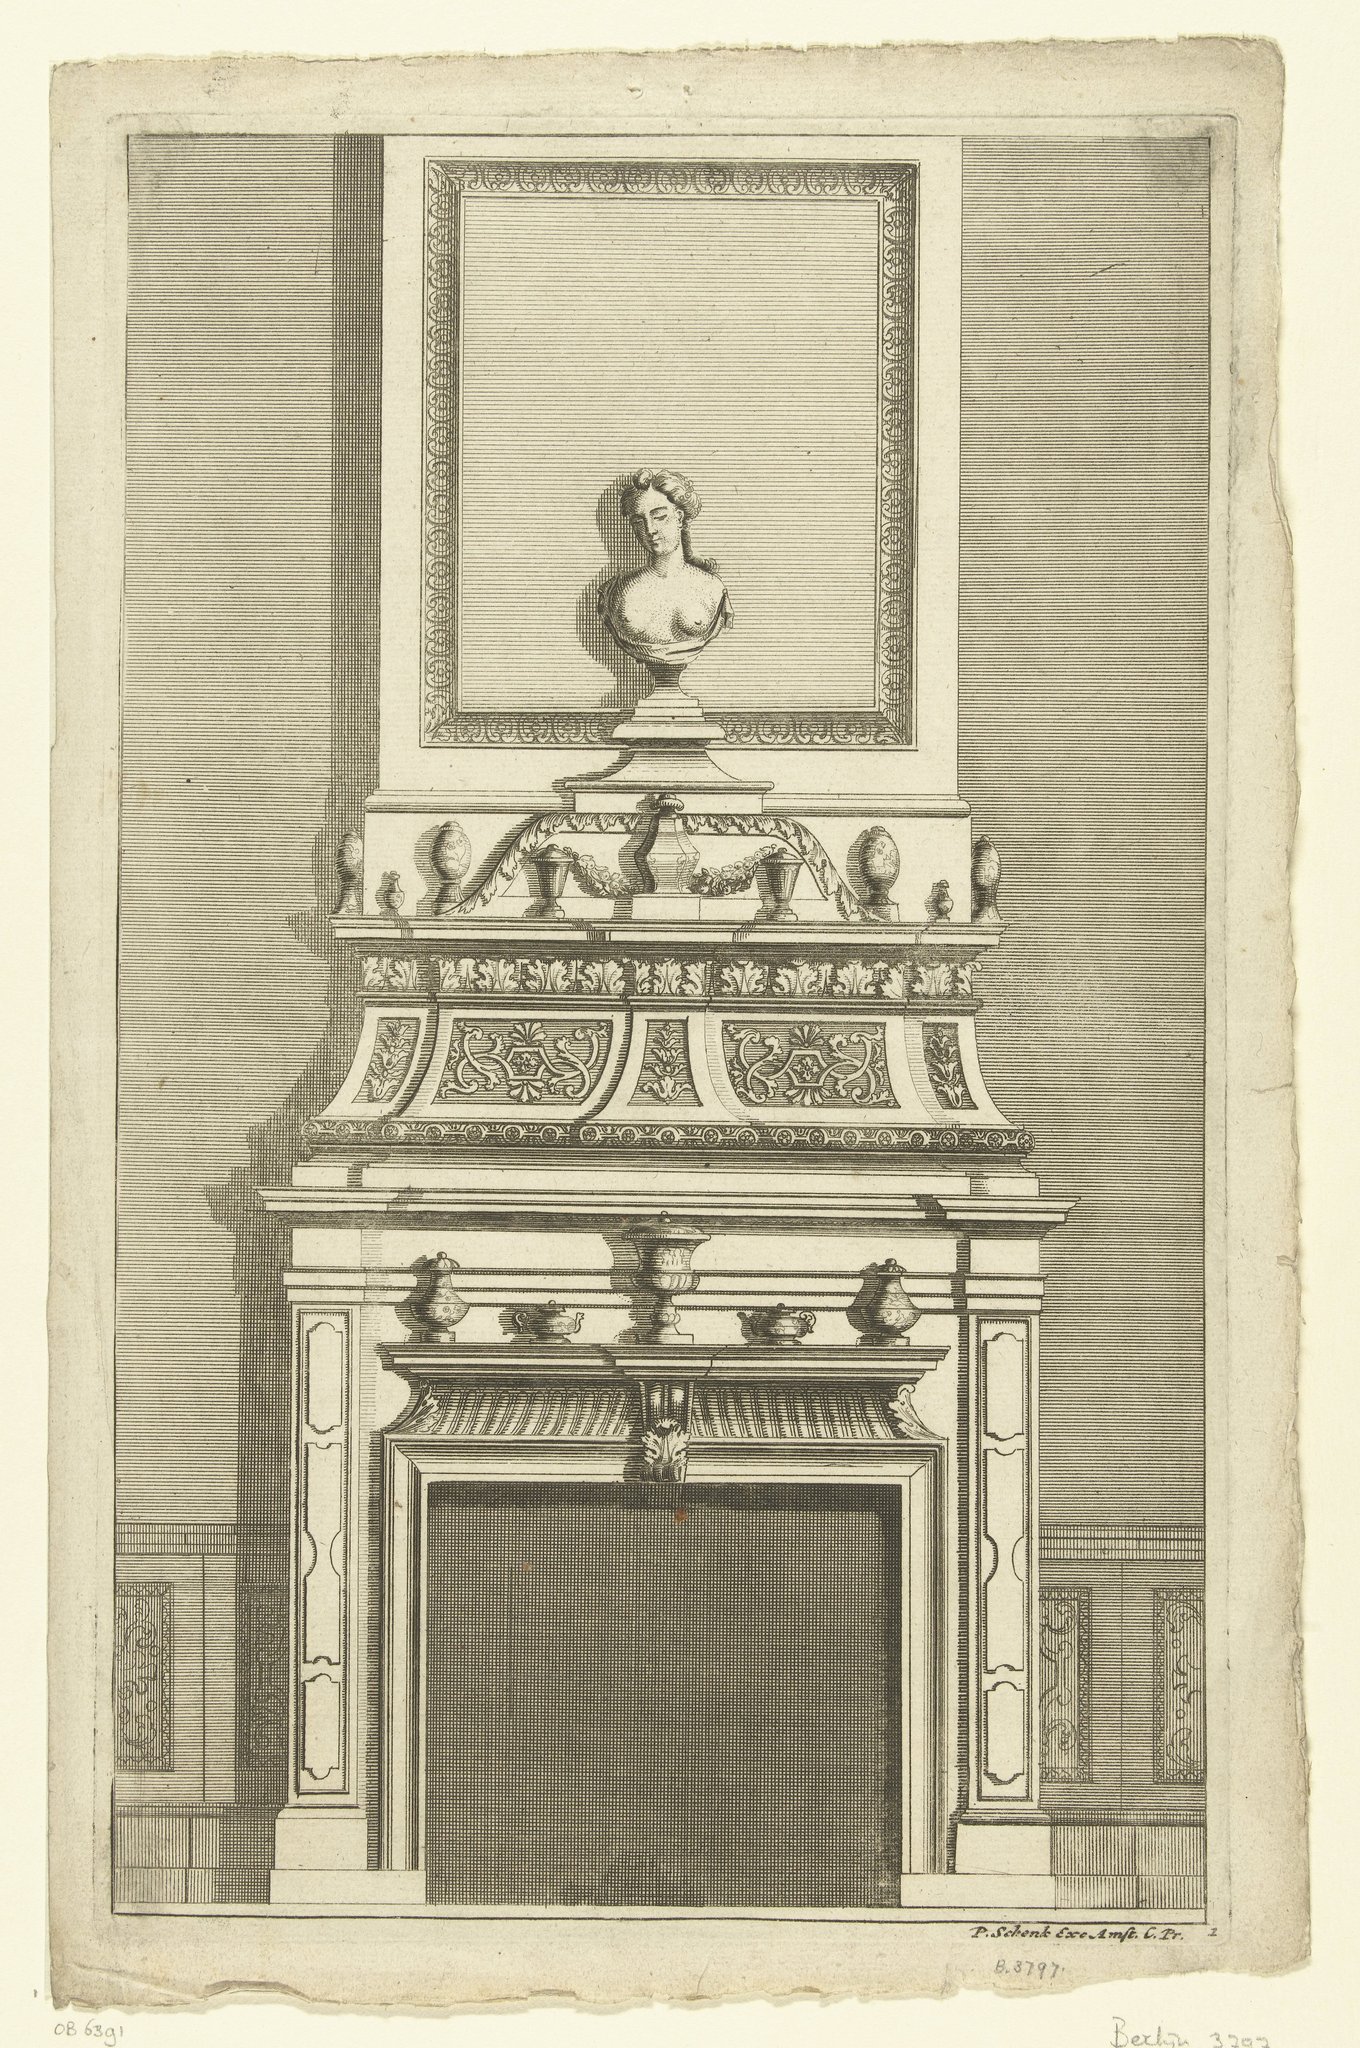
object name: print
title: Onderboezem met veertien vazen en theepotten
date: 1680-1700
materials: paper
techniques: etching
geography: amsterdam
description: Onderboezem met twee platen waarop negen en vijf Chinese vazen en theepotten staan. Voor de spiegel staat een portretbuste van een vrouw.